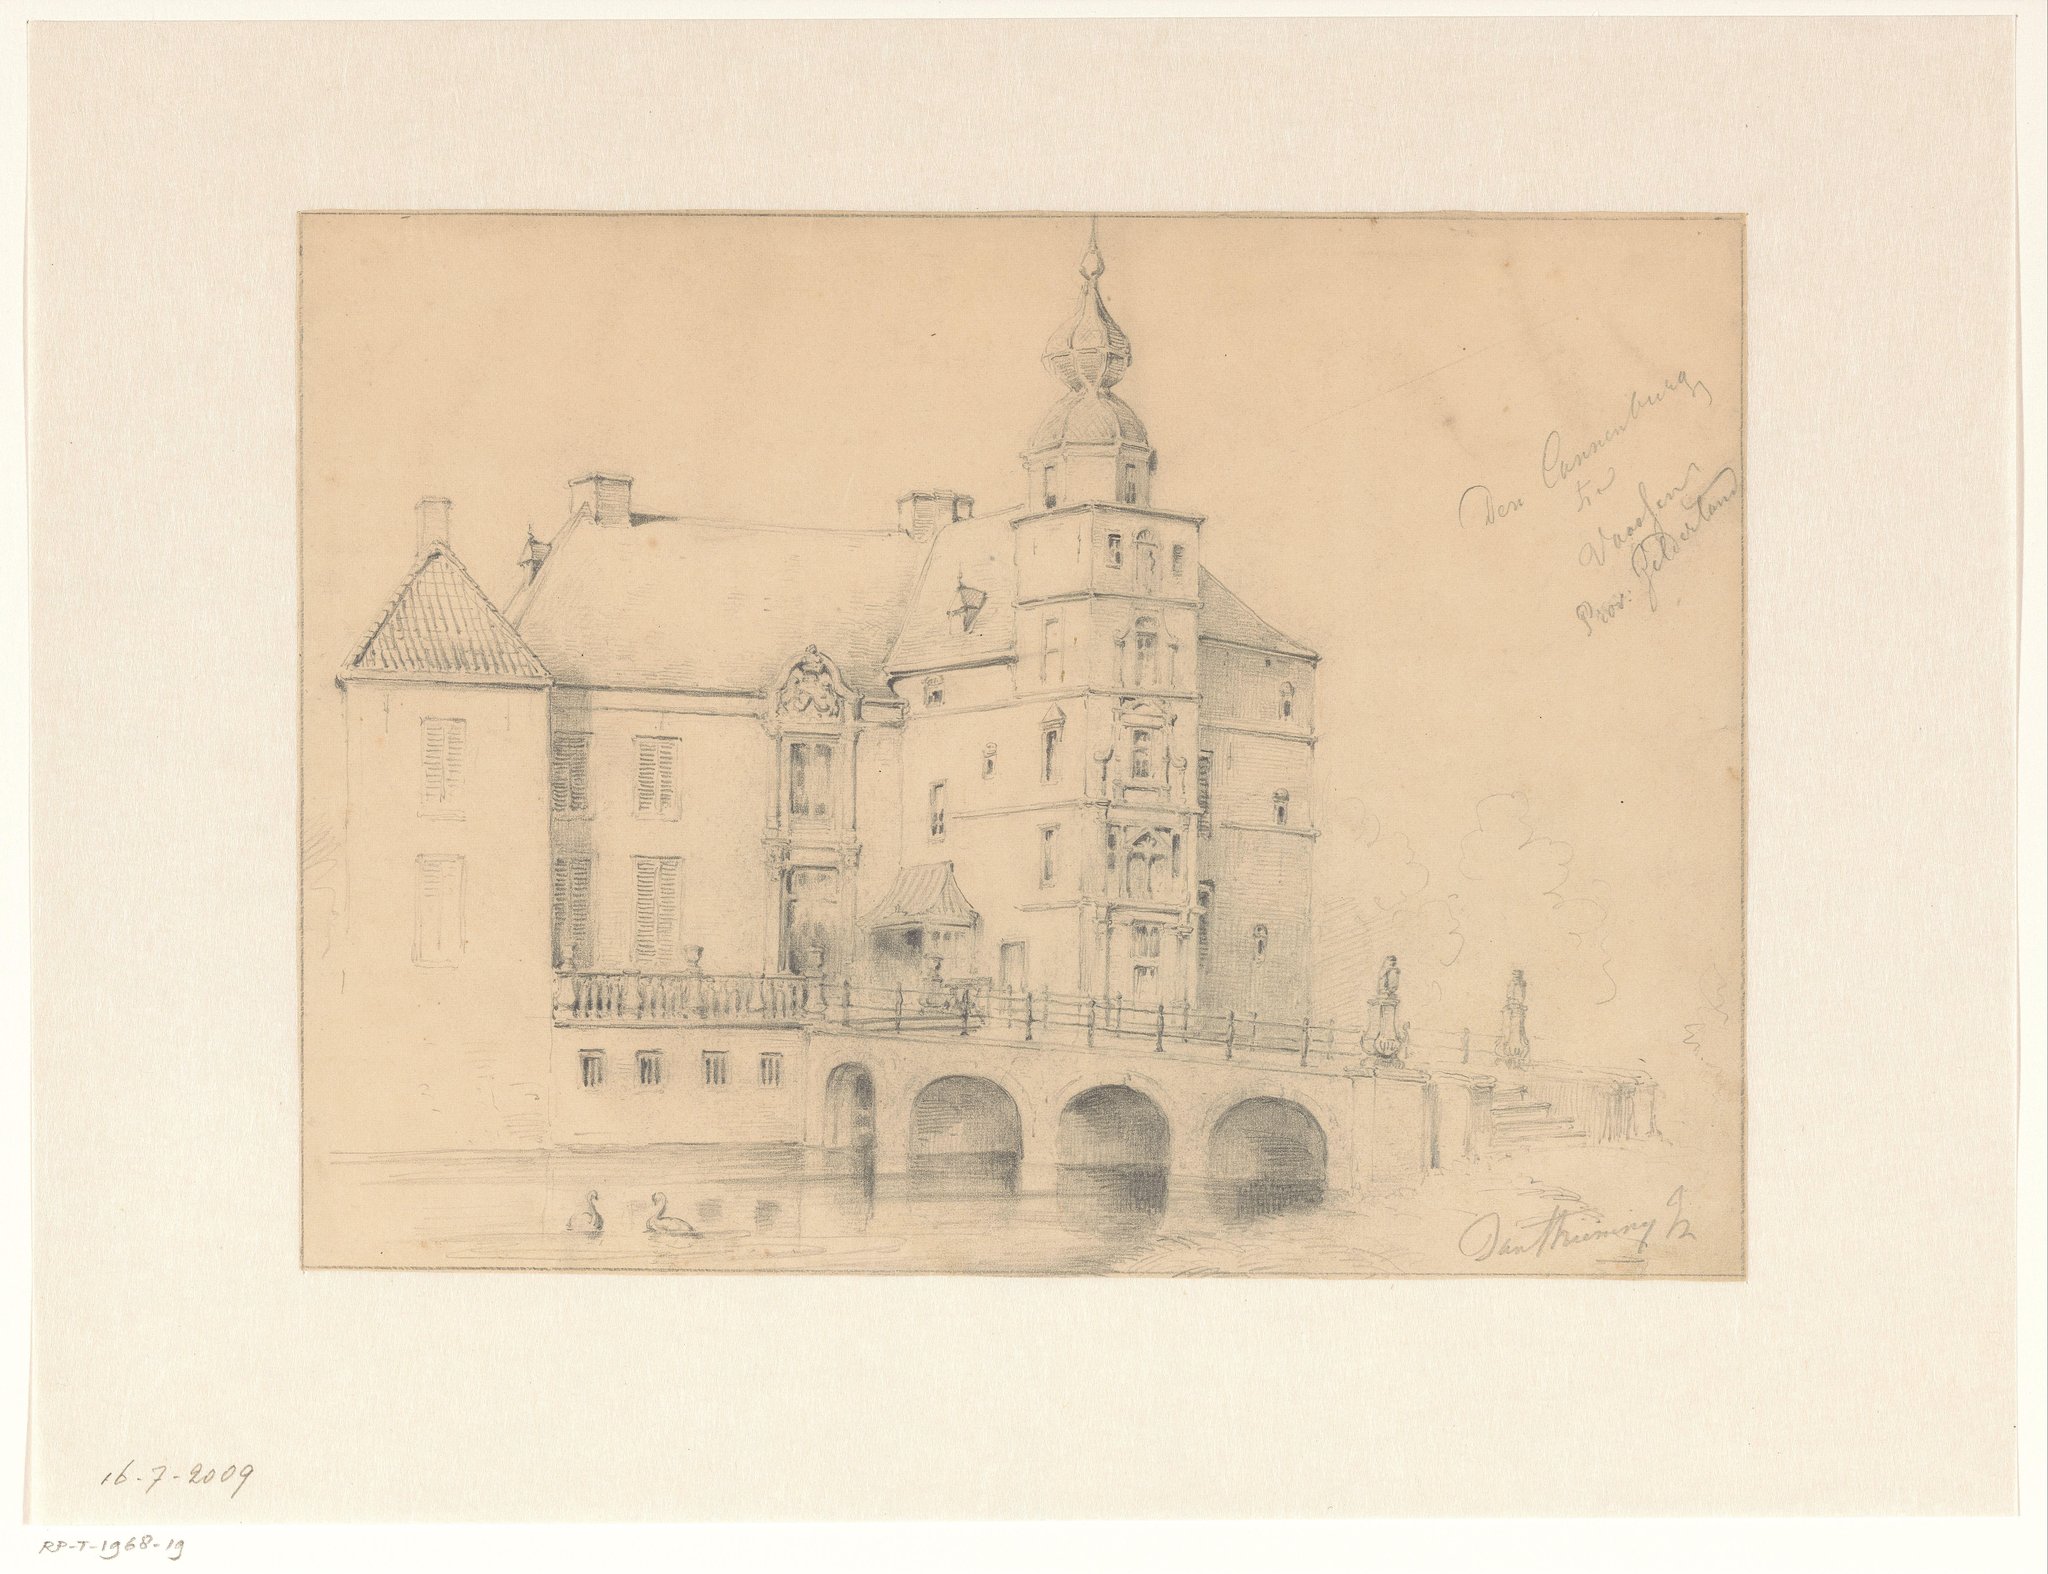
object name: drawing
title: Kasteel Cannenburg te Vaassen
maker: jan striening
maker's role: draughtsman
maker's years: 1827-1903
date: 1837-1903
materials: paper, pencil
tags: castle